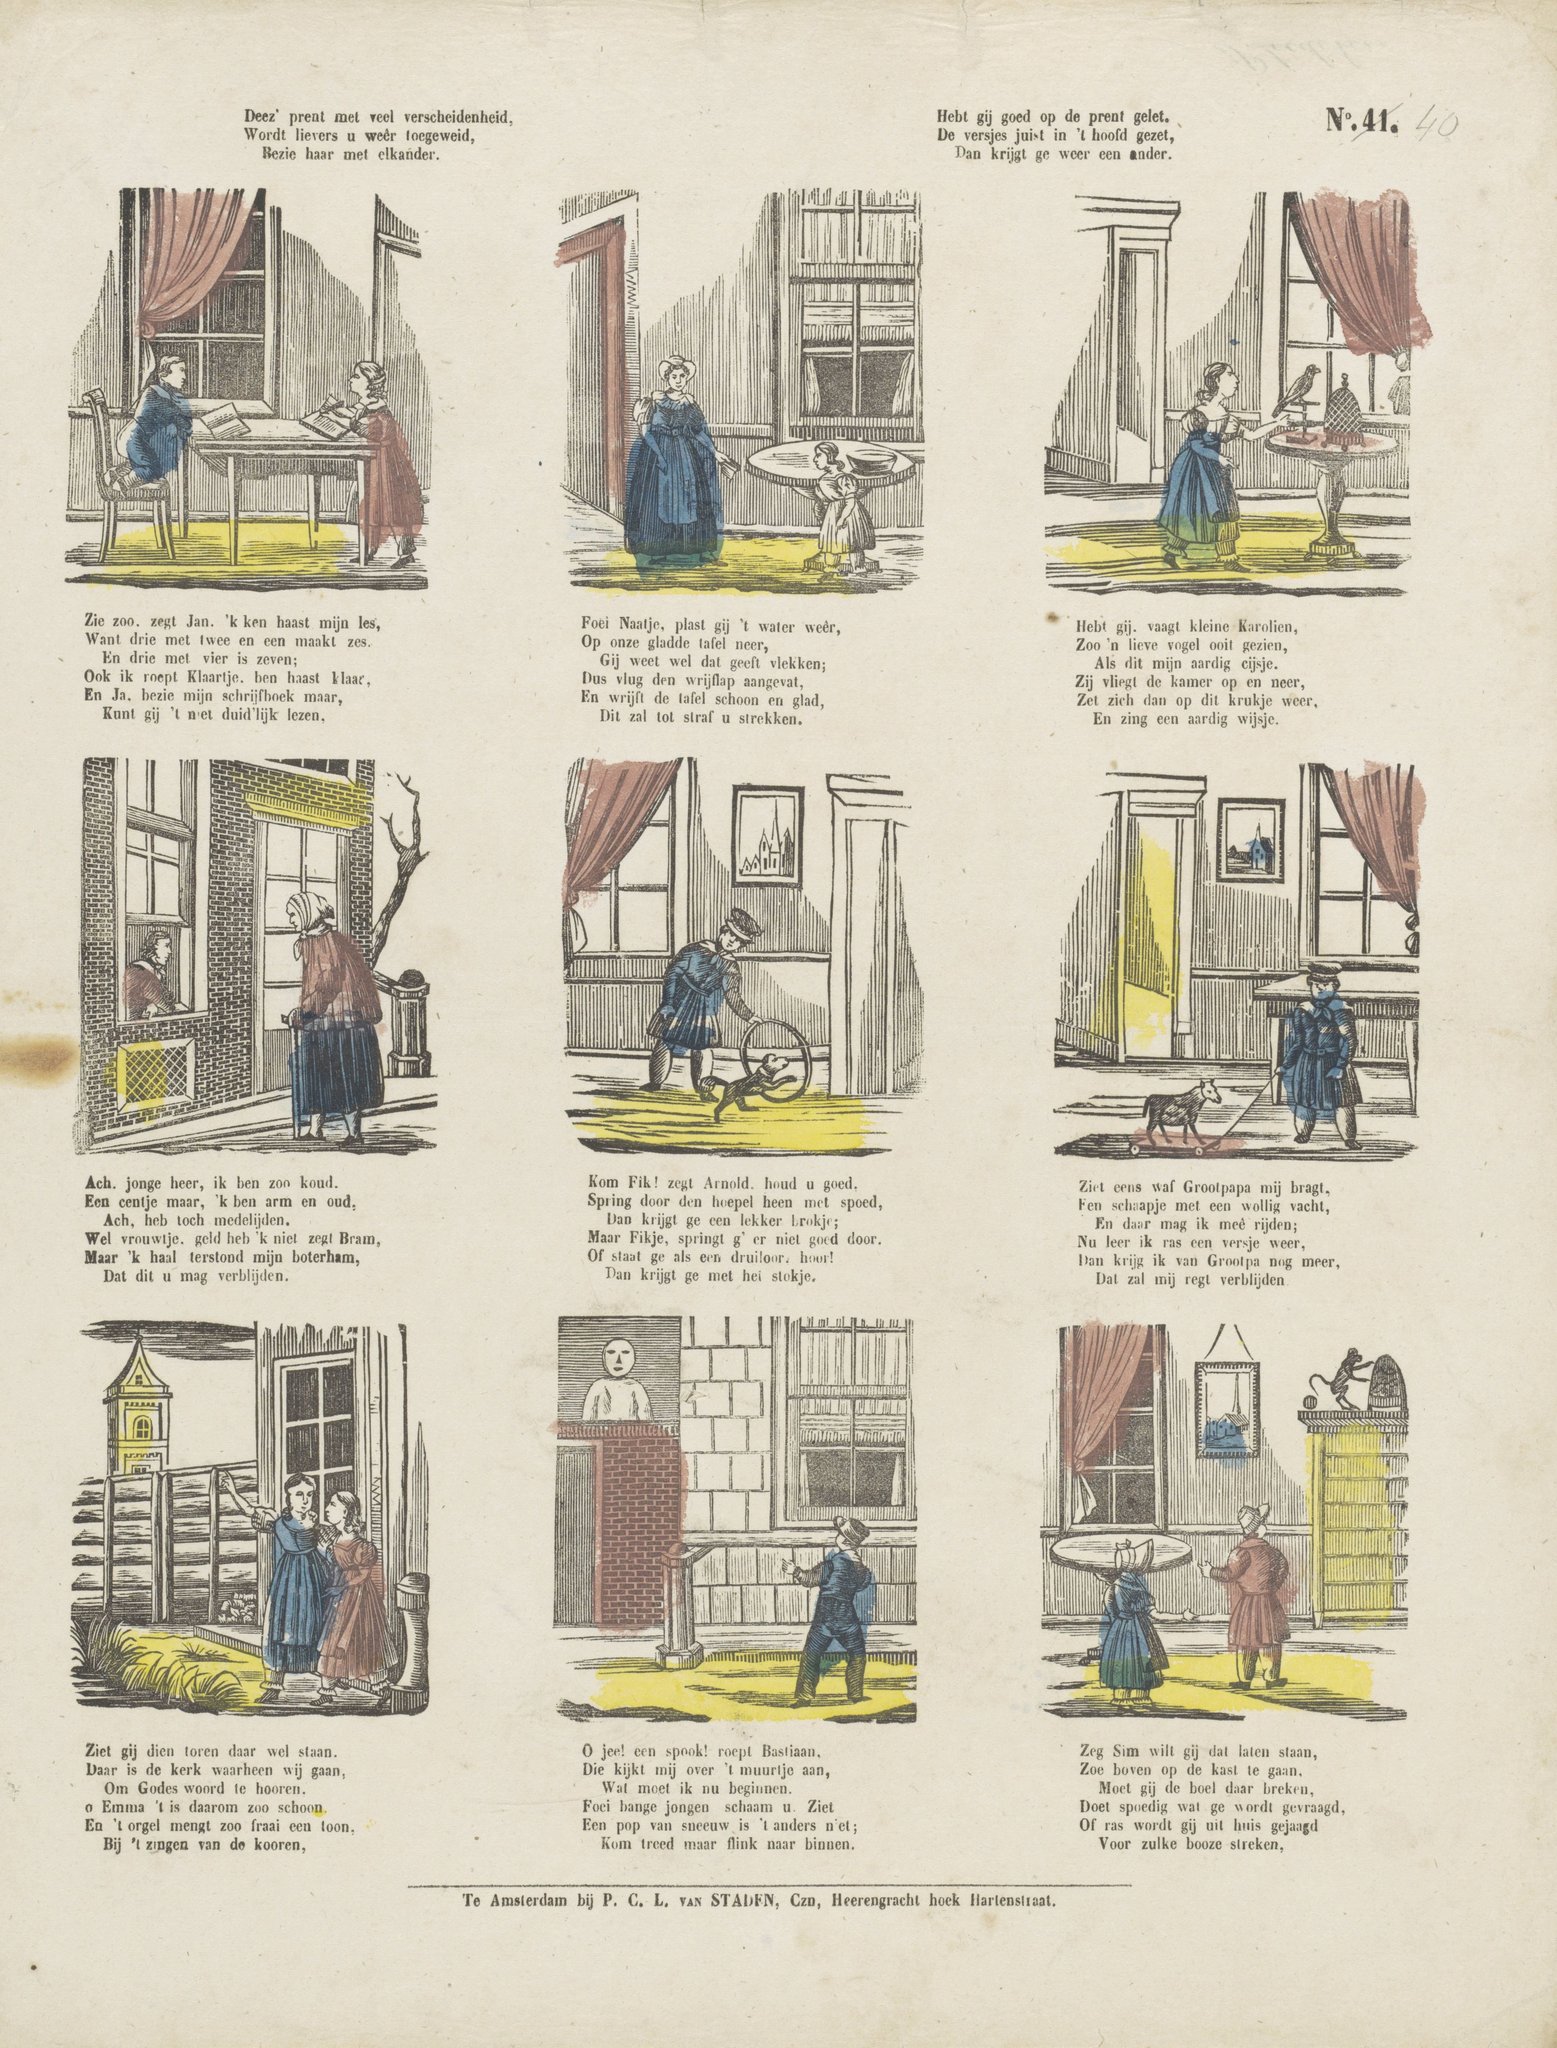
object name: print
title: Deez' prent met veel verscheidenheid, / Wordt lievers u weêr toegeweid [(...)]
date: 1850-1870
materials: paper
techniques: colour, letterpress printing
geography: netherlands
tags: children's games and plays, child, child playing with animals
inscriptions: collector's mark: Lugt 2760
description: Blad met 9 taferelen met kinderen. Onder elke afbeelding een zesregelig vers. Rechtsboven genummerd: No. 40.